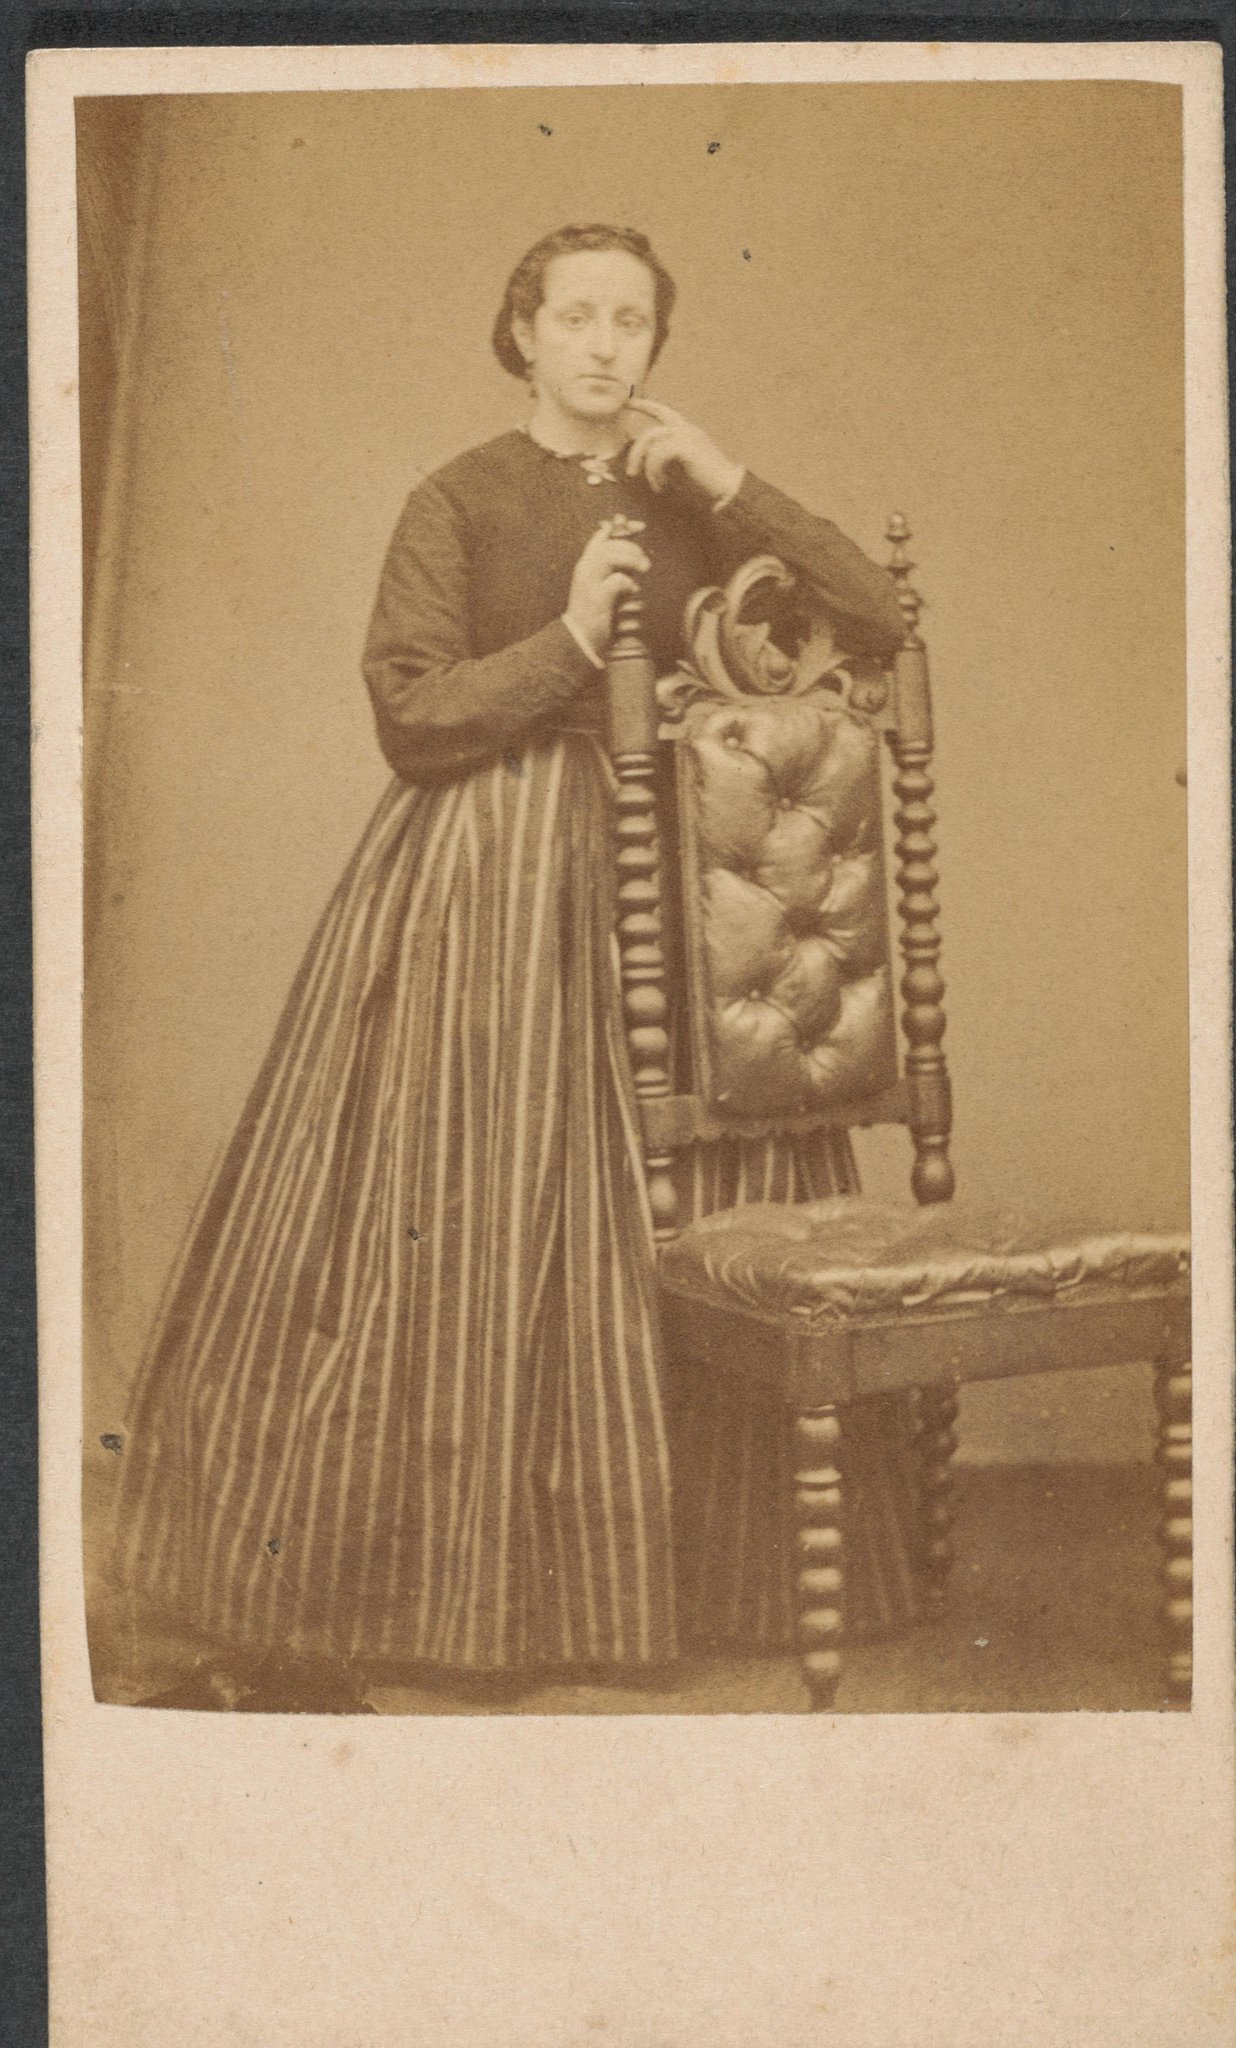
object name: photograph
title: Portret van een onbekende vrouw uit de familie Marmelstein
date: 1850-1900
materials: cardboard, photographic support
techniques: albumen print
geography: amsterdam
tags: adult woman, historical persons